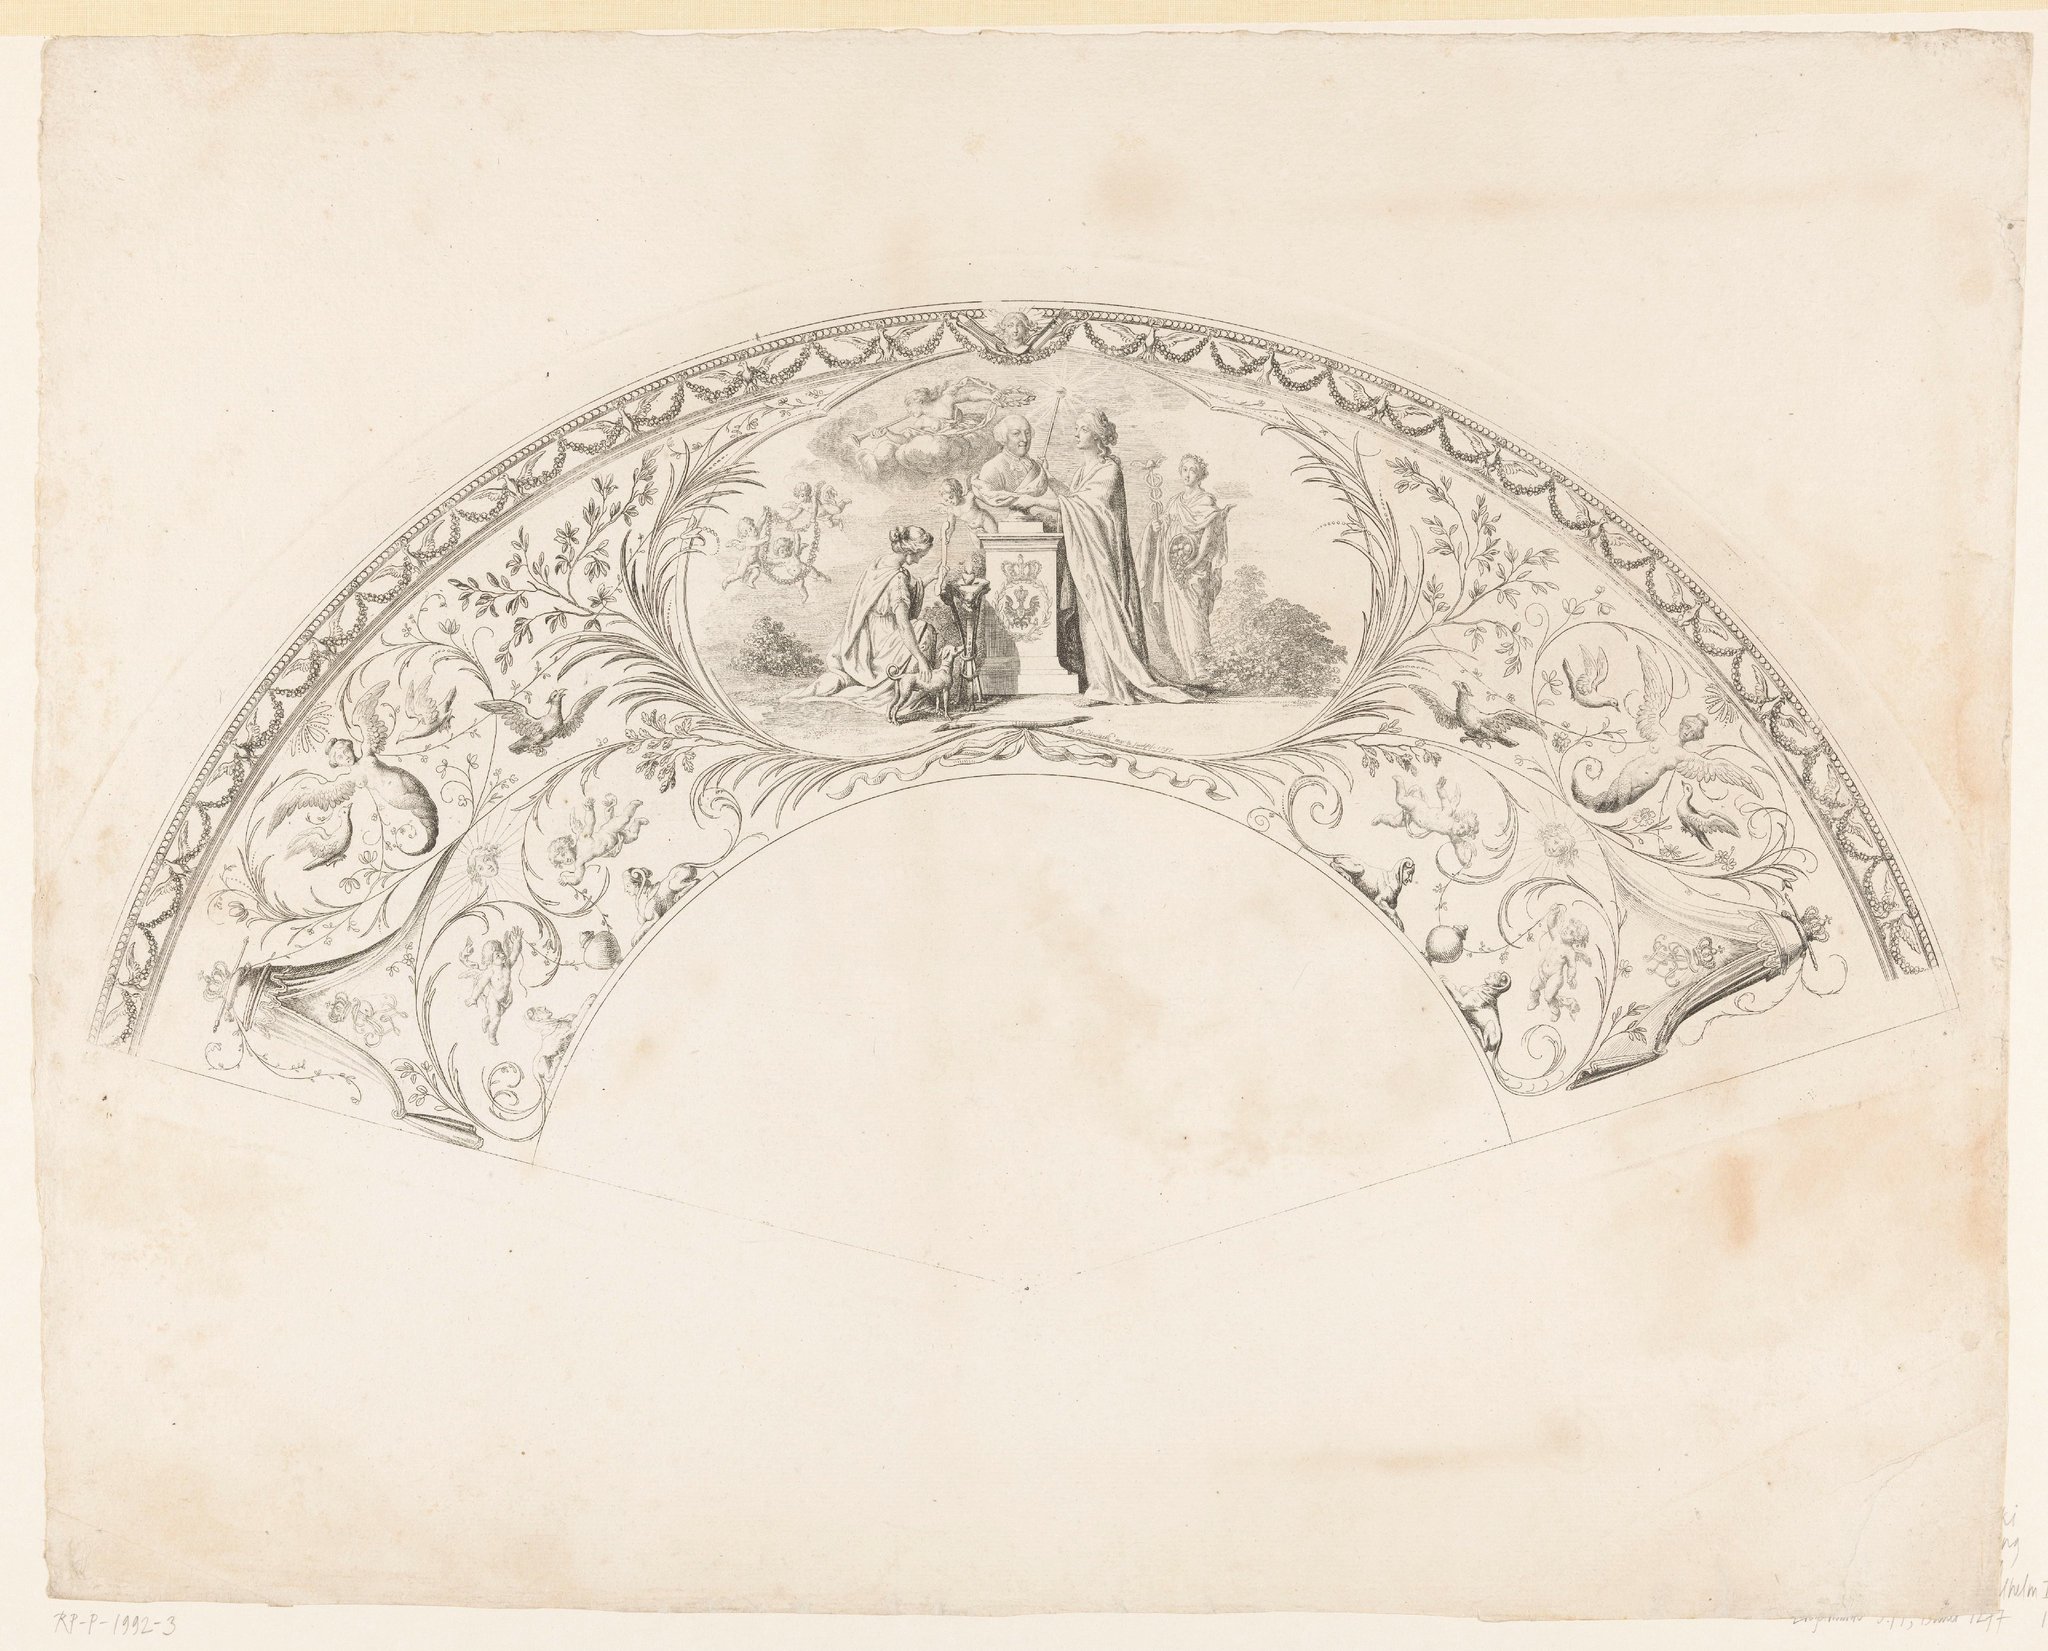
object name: print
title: Allegorie op de inhuldiging van Frederik Willem II, koning van Pruisen, te Königsberg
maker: daniel nikolaus chodowiecki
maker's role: draughtsman, print maker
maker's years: 1726-1801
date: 1787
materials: paper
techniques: etching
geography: berlin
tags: berlin, frederik willem ii (koning van pruisen), curtains, sphinx (lion/woman); 'sfinge' (ripa) - aa - female human figure, 'cornucopia', horn of plenty, chest, bust, heart symbolism, lyre, cithara, psaltery, garland, wreath, fame; 'fama', 'fama buona', 'fama chiara' (ripa) (+ abstract concept represented by female figure), archer's weapons: arrow, dog (with name of kind), sirens (classical mythology), caduceus (staff with two snakes, attribute of mercury), cupids: 'amores', 'amoretti', 'putti', crowning the victor with laurel, letter combinations such as letterword, anagram, letter square, monogram, etc., the all-seeing eye, triangle with eye ~ symbol of god the father (+ variant)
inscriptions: collector's mark: Lugt 2228, date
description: Prent in waaiervorm. Tweede prent in deze vorm, mogelijk de achterzijde, is tevens in het bezit van het RMA.